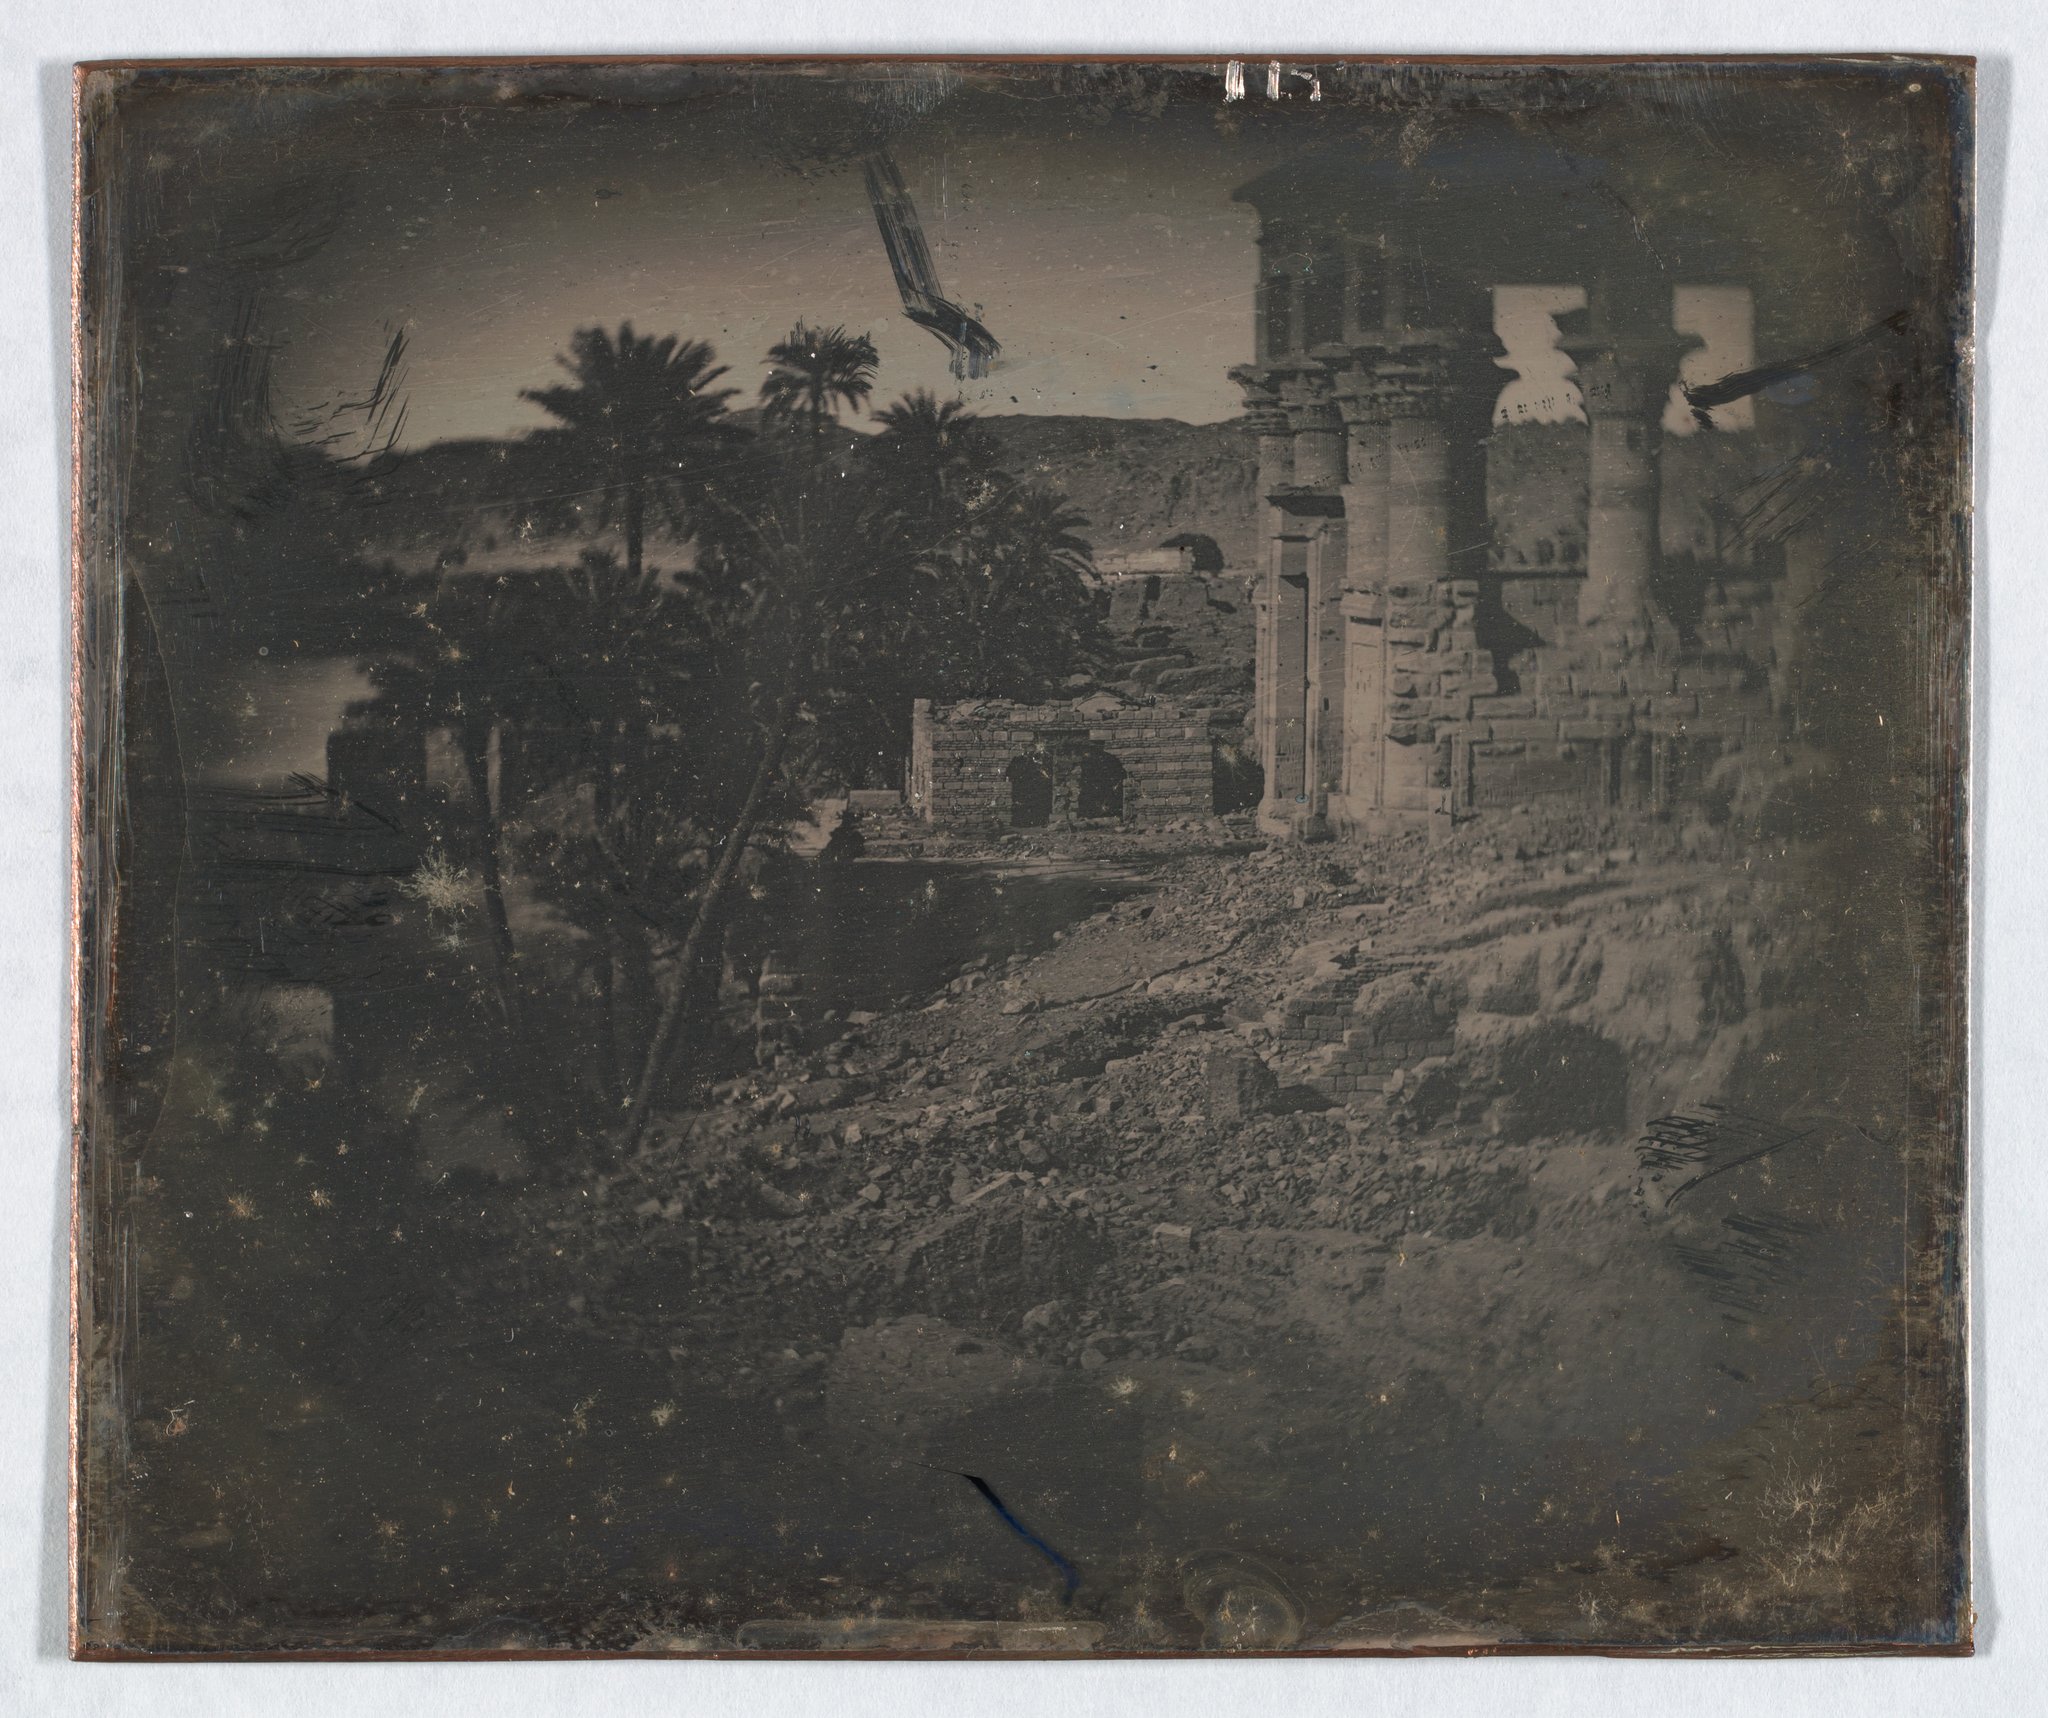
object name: photograph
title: Temple and Date Palms, Philae (236. Philé T. découvert et P. dattiers)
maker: joseph-philibert girault de prangey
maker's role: artist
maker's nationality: french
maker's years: 1804-1892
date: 1844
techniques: daguerreotype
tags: architecture,temples,ruins